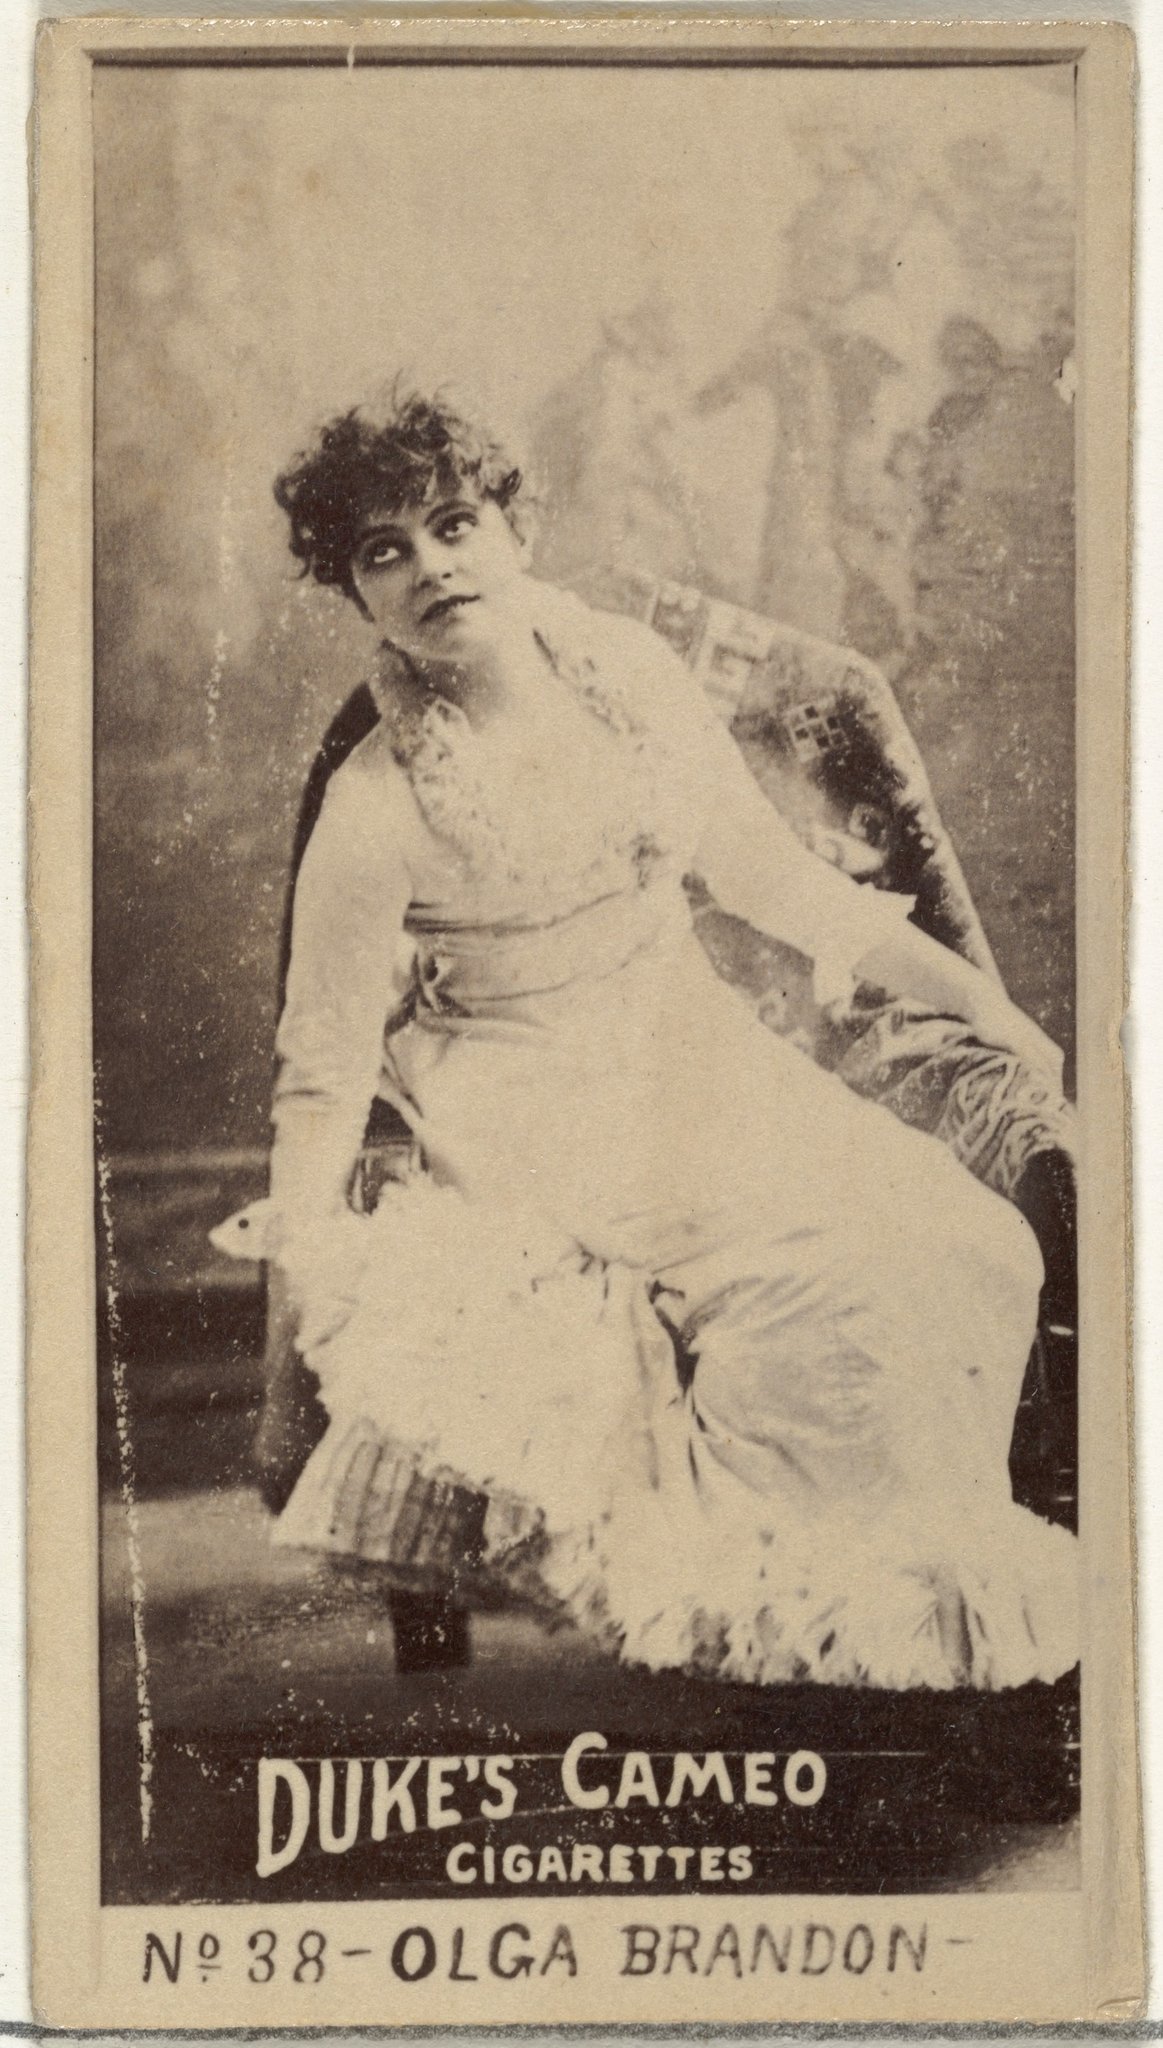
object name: photograph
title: Card Number 38, Olga Brandon, from the Actors and Actresses series (N145-4) issued by Duke Sons & Co. to promote Cameo Cigarettes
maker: w. duke, sons & co.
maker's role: publisher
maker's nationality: american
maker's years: 1870-1920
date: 1880-1889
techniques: albumen silver print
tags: portraits,women,actresses